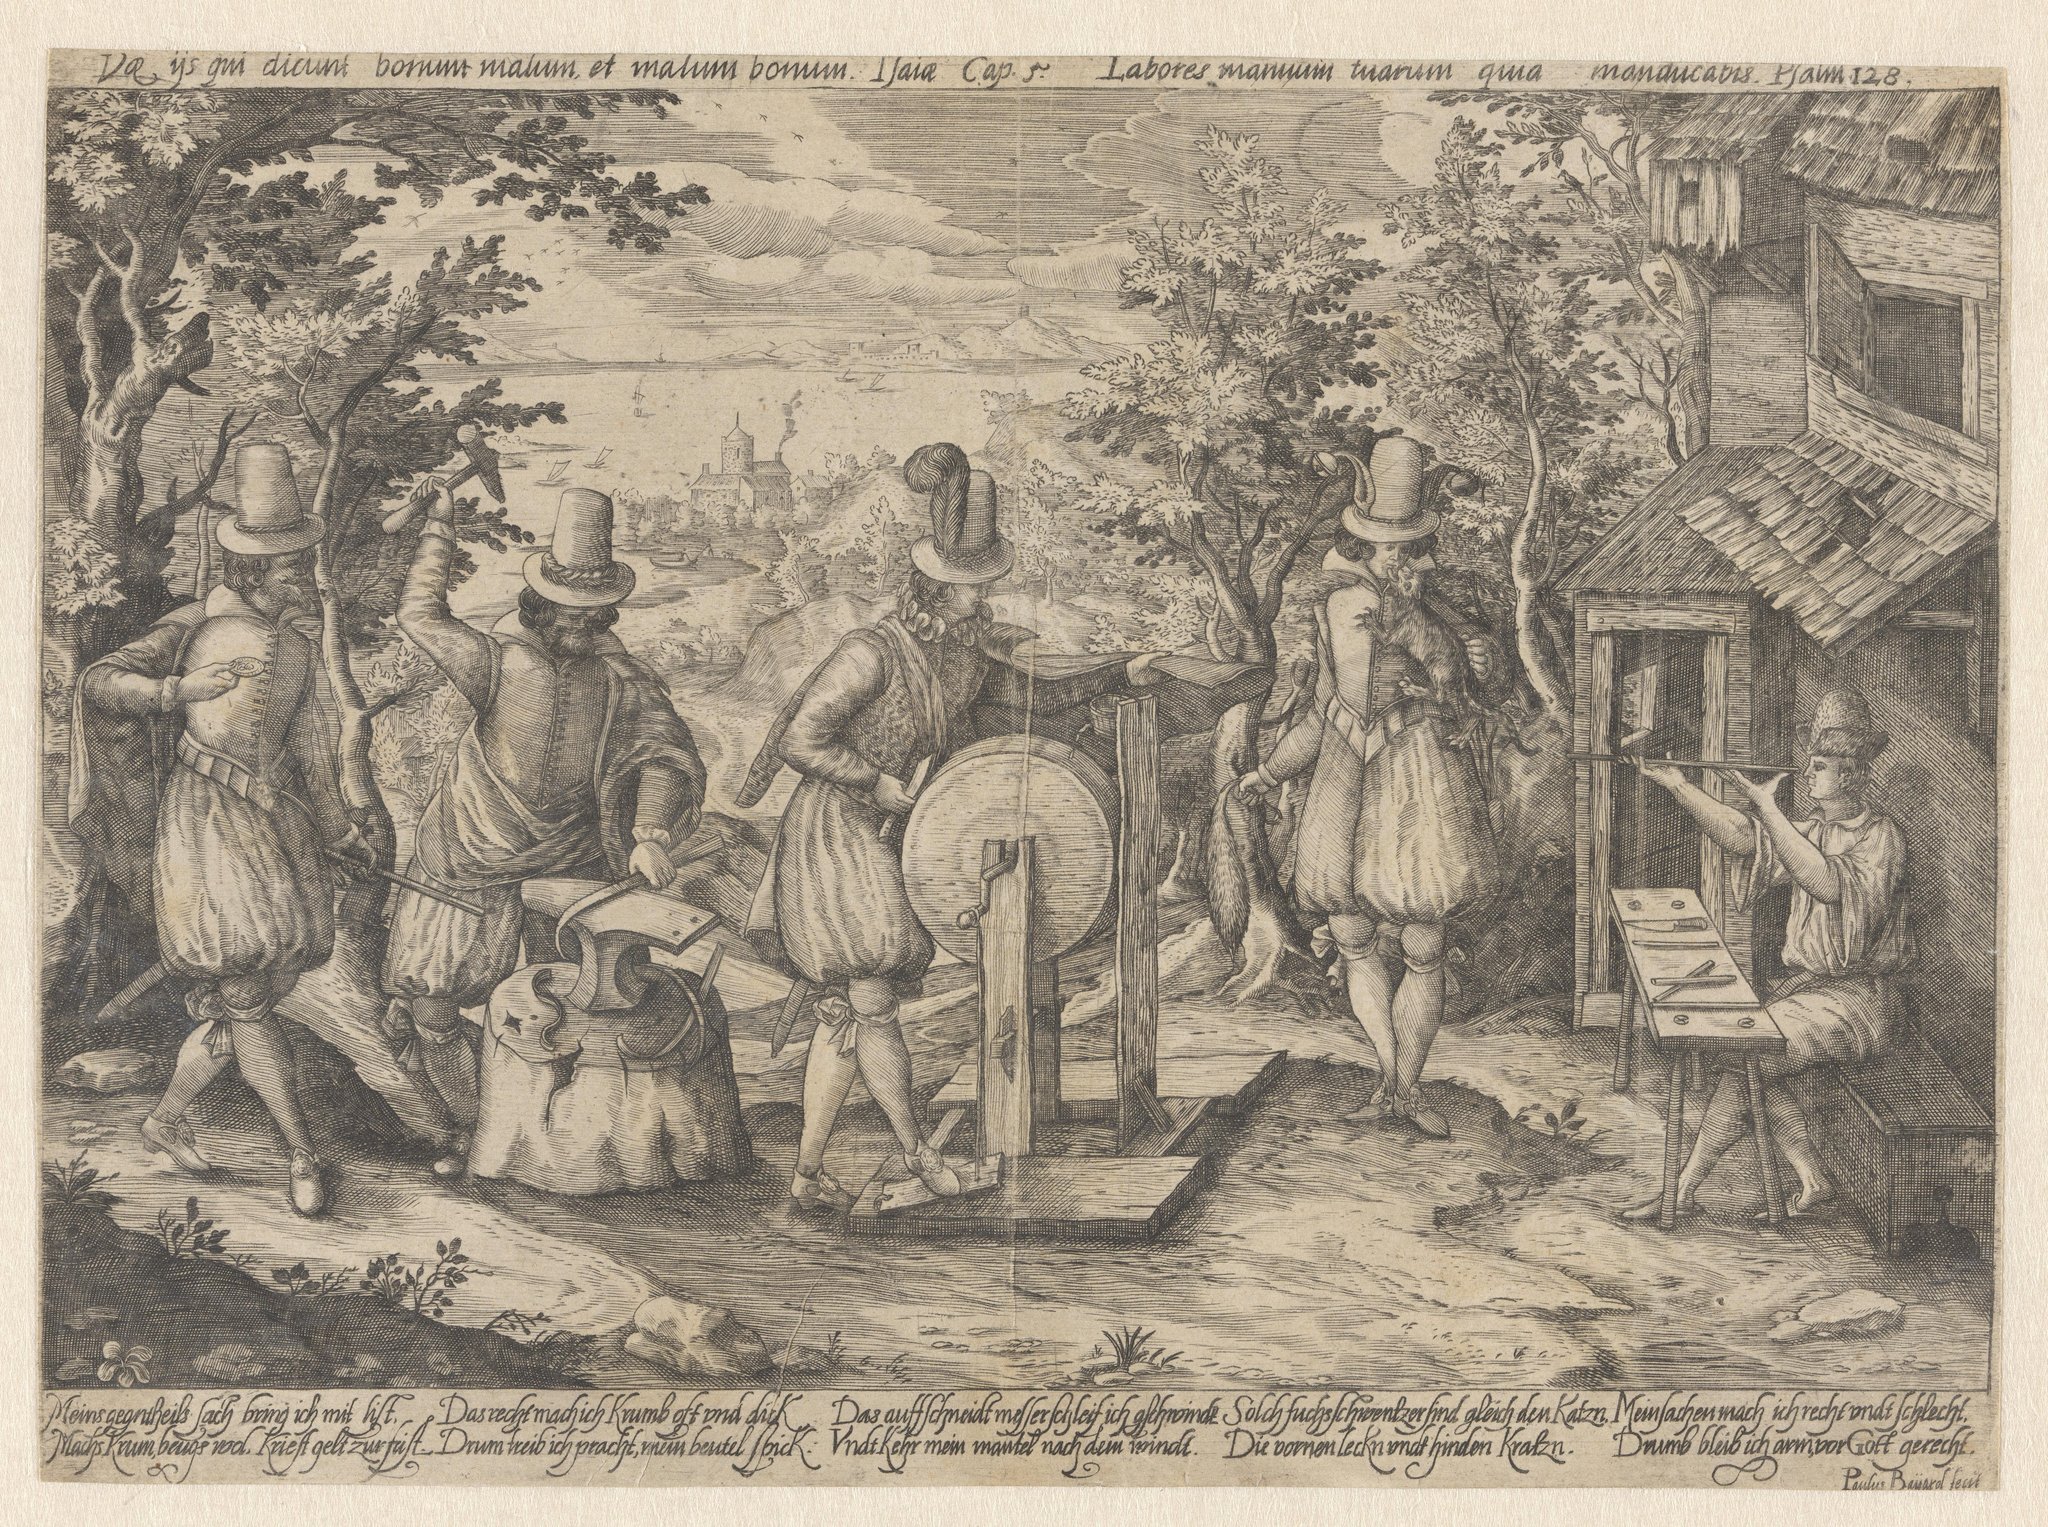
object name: print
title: Allegorische voorstelling op het wangedrag van rijken en de rechtschapenheid van ambachtslieden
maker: paulus baijard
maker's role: print maker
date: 1580-1630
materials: ink, paper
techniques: engraving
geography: germany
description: In een landschap vier rijk geklede mannen die verschillende soorten wangedrag verbeelden. Deze worden beschreven in tweeregelige Duitse onderschriften. De man links, met een geldstuk in zijn ene en een stok of staaf in zijn andere, buigt met list en geld krom wat recht is, recht wat krom is. De tweede figuur slaat een stuk metaal krom op een aambeeld. Hij maakt krom wat recht is door prachtvol gedrag en het spekken van zijn buidel. De derde figuur slijpt een mes op een slijpsteen en houdt zijn mantel omhoog. Volgens het onderschrift slijpt hij het mes bot en hangt zijn mantel naar de wind (draait met alle winden mee). De vierde figuur houdt in zijn ene hand een vossenstaart en met zijn andere een kat vast die zijn gezicht likt. Volgens het onderschrift zijn Vossenstaarten (een bijnaam voor onbetrouwbare lieden) zoals katten die van voren likken en van achteren krabben. Geheel rechts is een ambachtsman voorgesteld zittend voor een schamel huis, die een stok, staaf of een buis voor zijn oog houdt om te zien of deze recht is. Volgens het onderschrift gedraagt deze man zich in alles eenvoudig en goed en blijft daarom arm, maar rechtvaardig in de ogen van God. In de bovenste marge een Latijns citaat uit Bijbelboek Jesaja: ‘Wee hen die het kwade goed noemen en het goede kwaad’ (Jesaja 5:20-21) en een regel uit psalm 128: ‘Want gij zult eten van de arbeid uwer handen.’